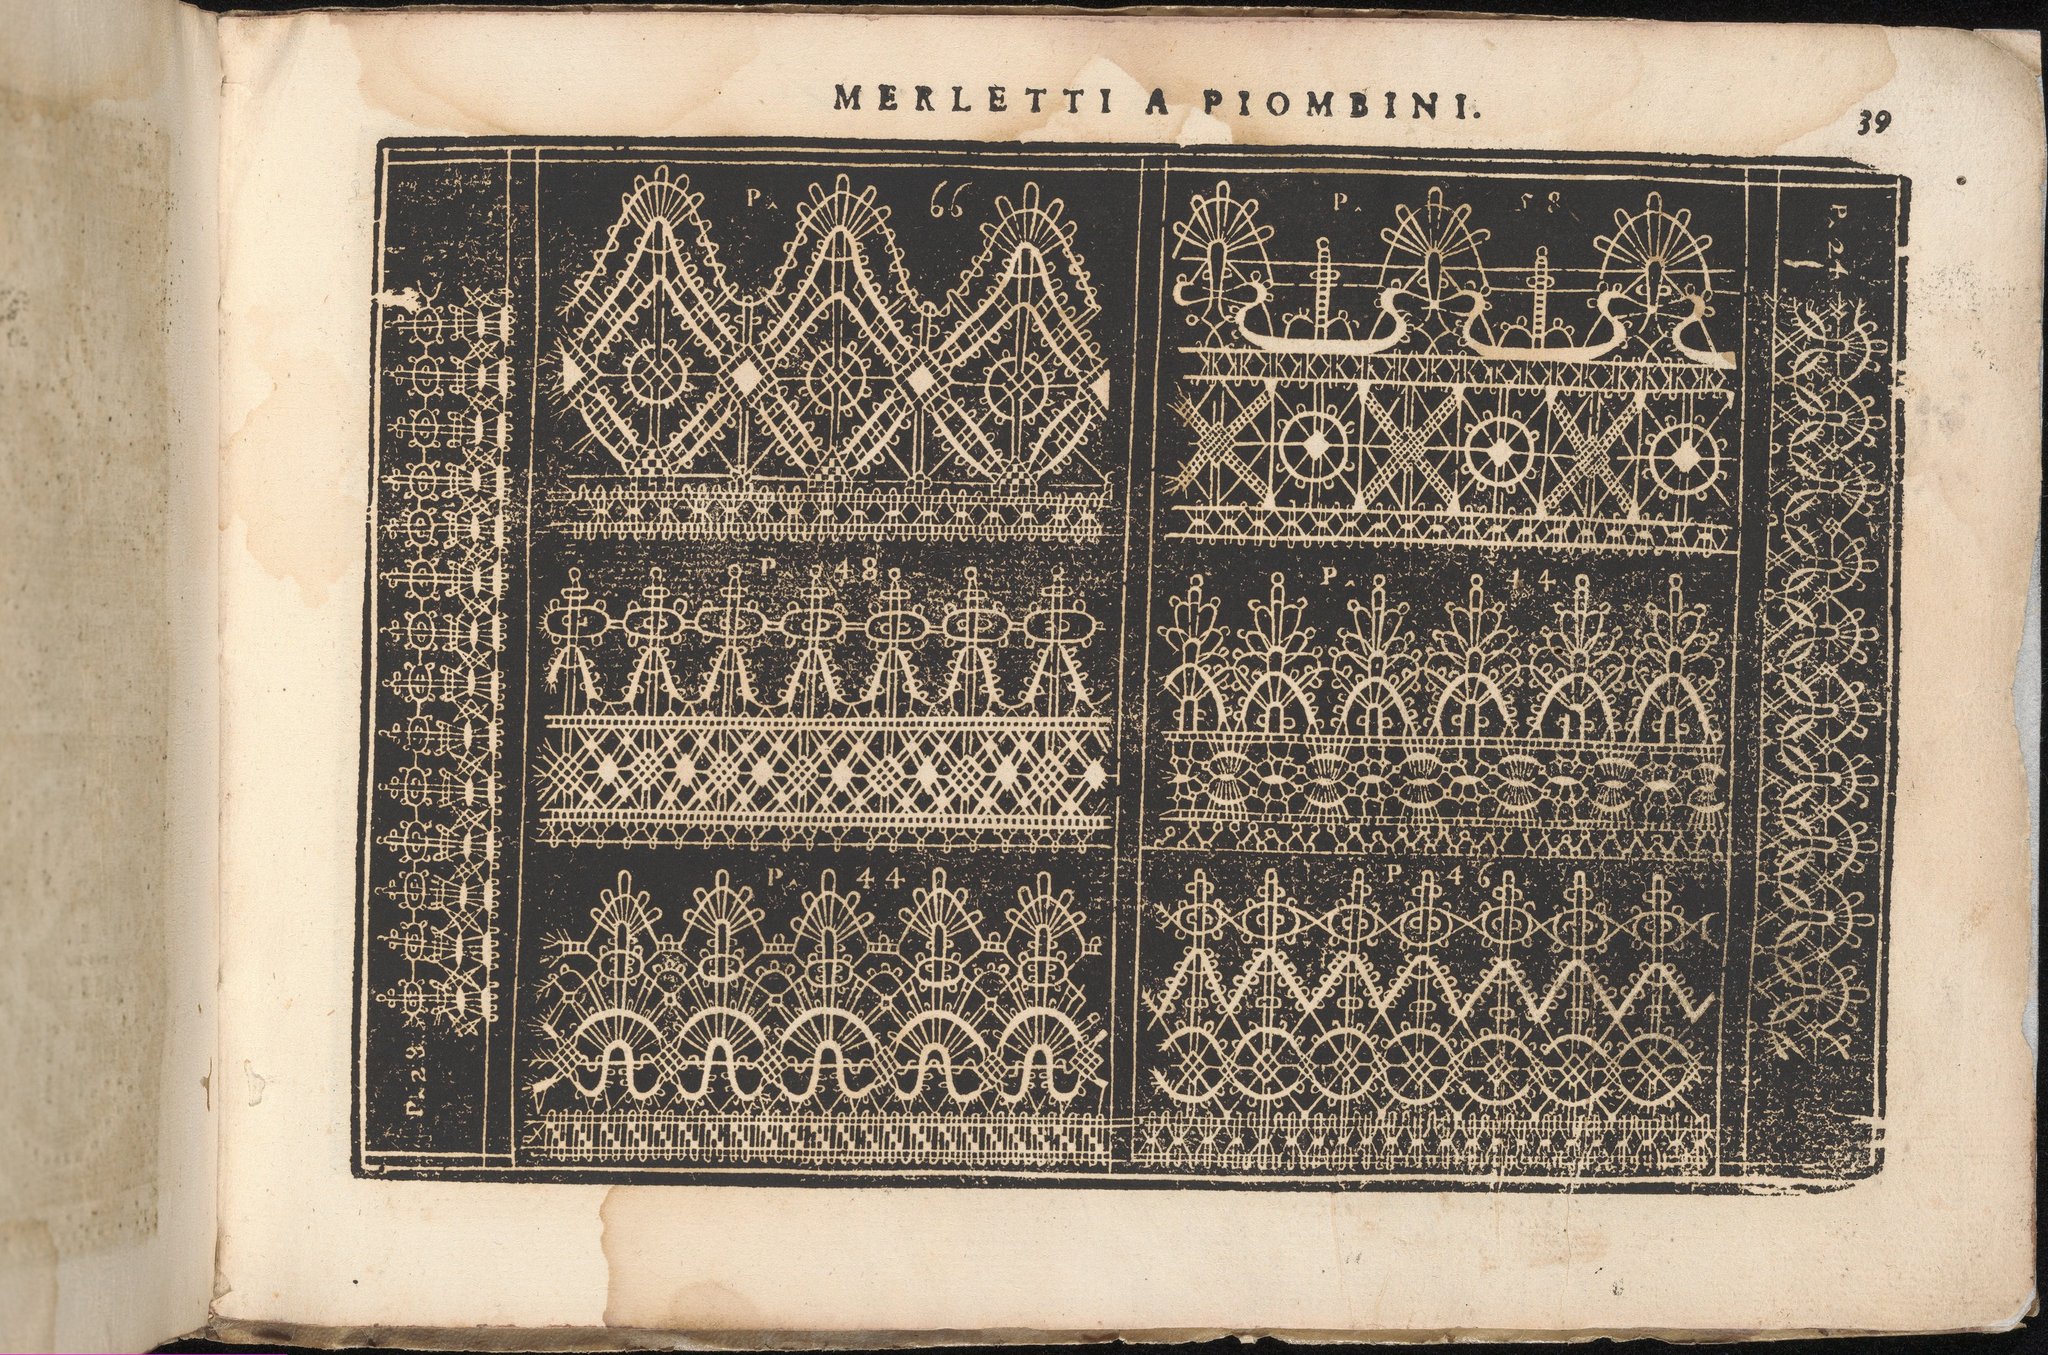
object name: book print ornament architecture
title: Teatro delle Nobili et Virtuose Donne..., page 45 (recto)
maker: isabella catanea parasole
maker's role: author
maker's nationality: italian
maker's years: 1565-1625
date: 1616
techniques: engraving, woodcut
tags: ornament